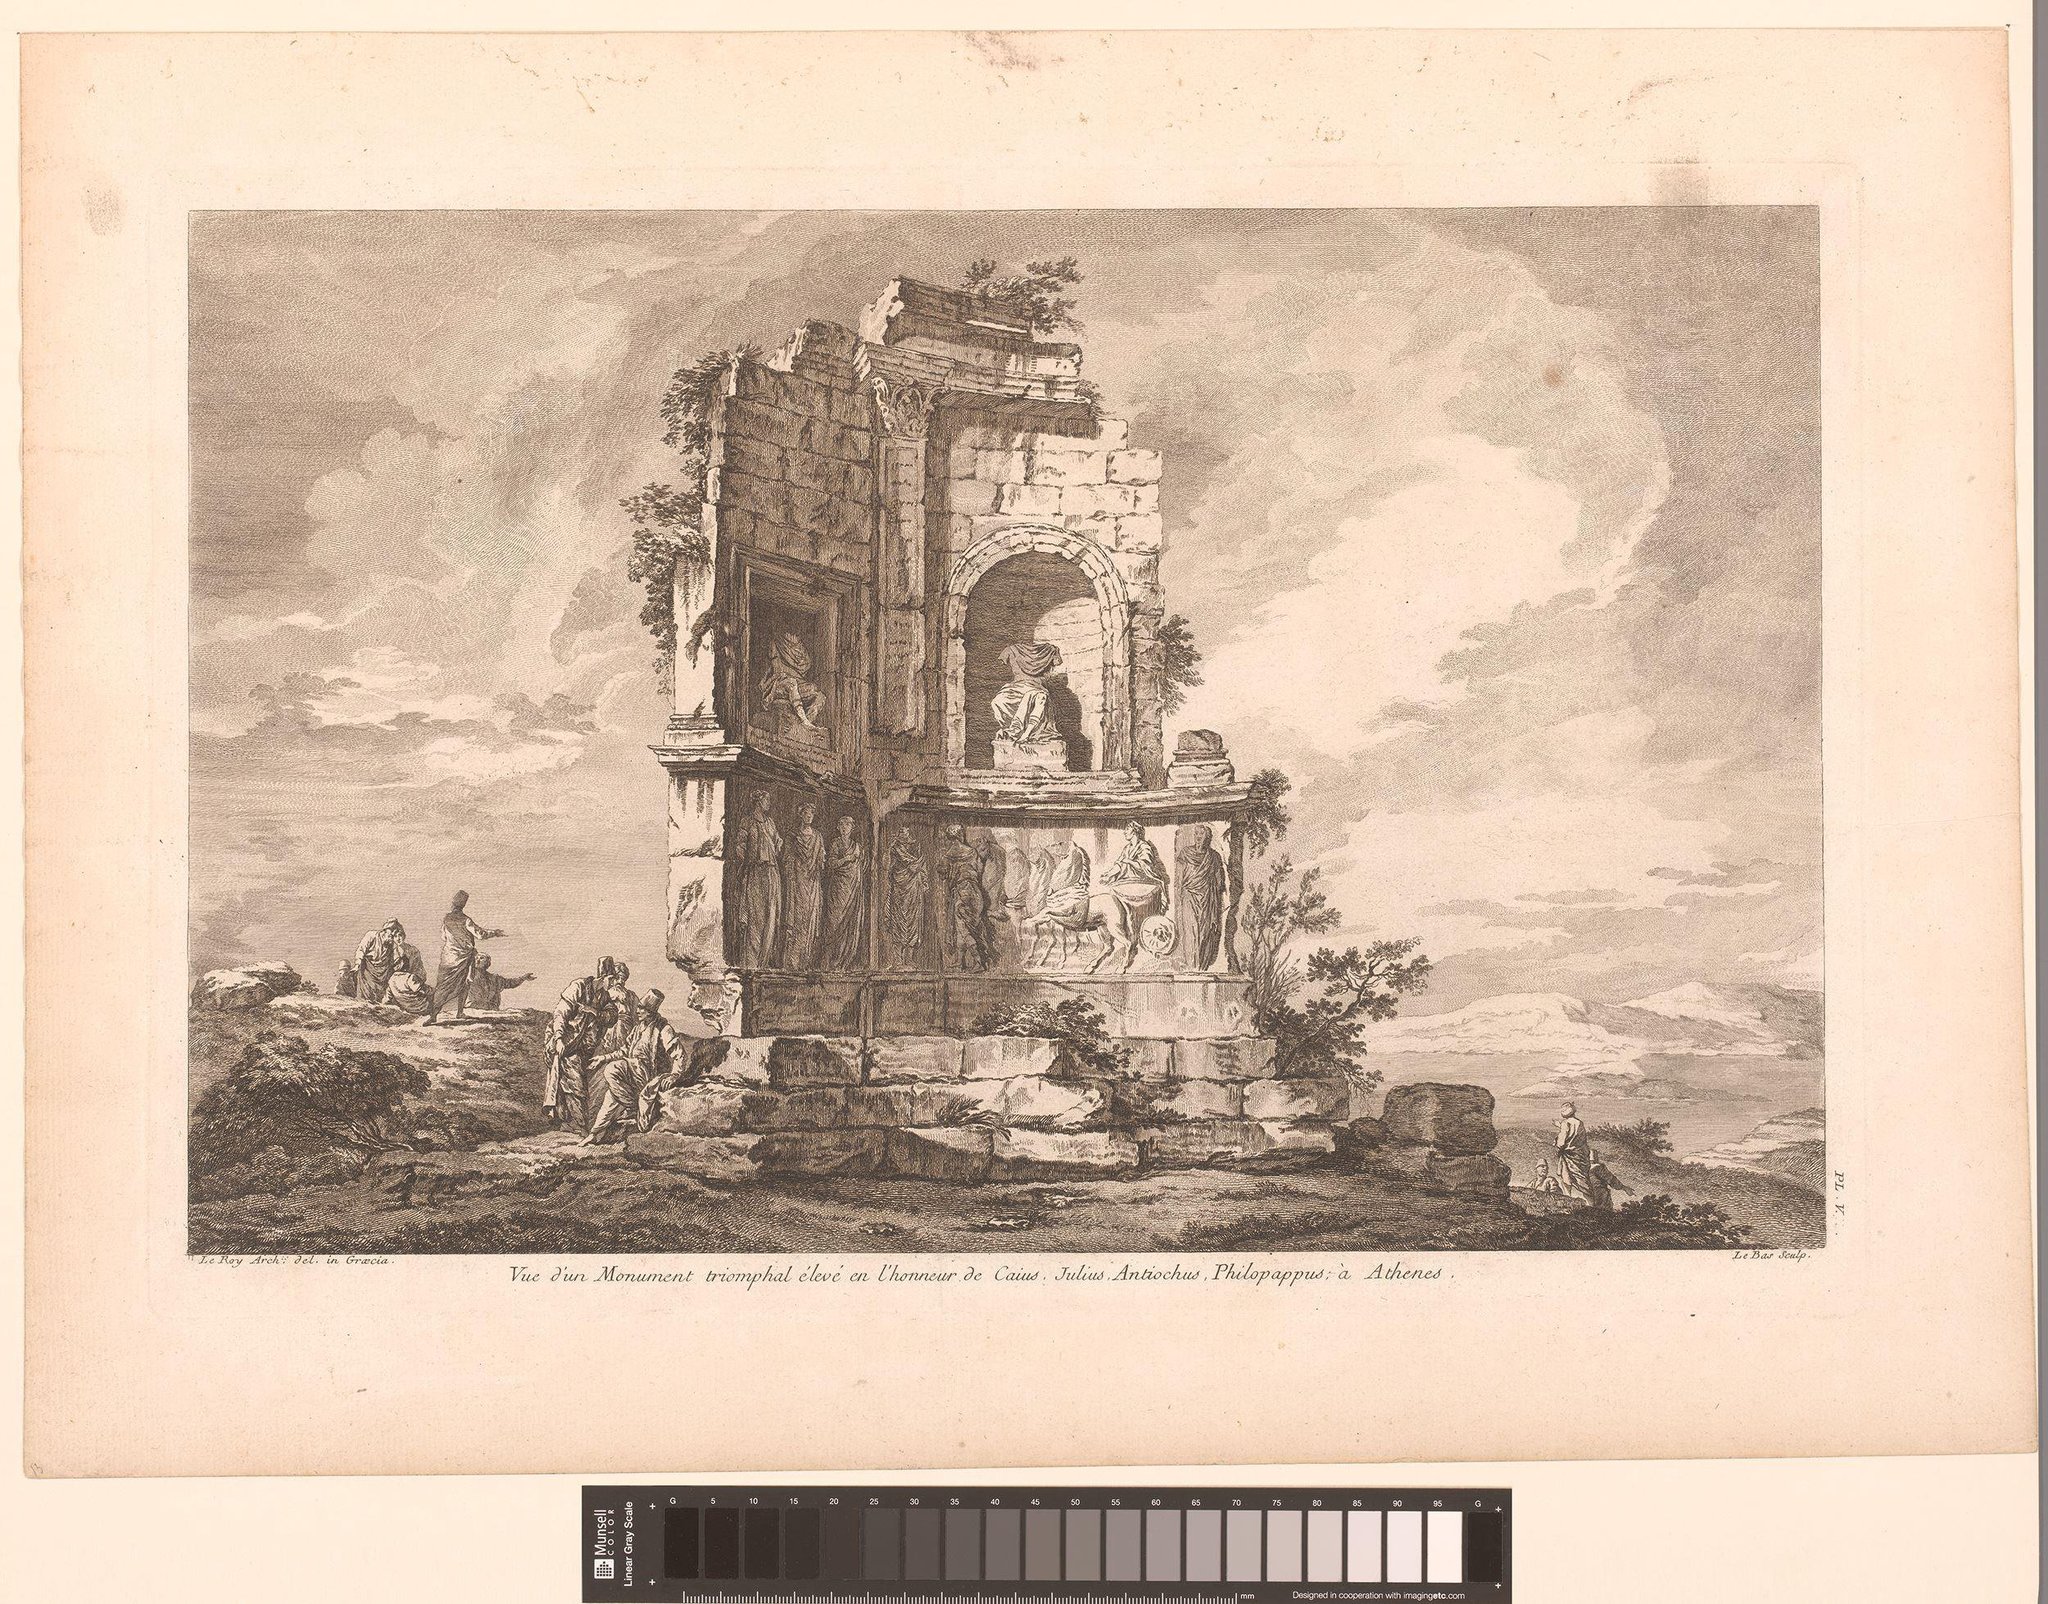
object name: book illustration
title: Vue d'un Monument triomphal élevé en l'honneur de Caius, Julius, Antiochus, Philopappus, à Athenes.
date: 1758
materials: paper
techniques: etching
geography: greece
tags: ruin of a building ~ architecture, landscape with ruins, monumental adornments (in city)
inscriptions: collector's mark: Lugt 2760, collector's mark: Lugt 2228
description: Prent uit: Le Roy, Julien. Ruines des plus beaux monuments de la Grêce. Parijs: Guérin & de La Tour, 1758. Dit betreft plaat V.